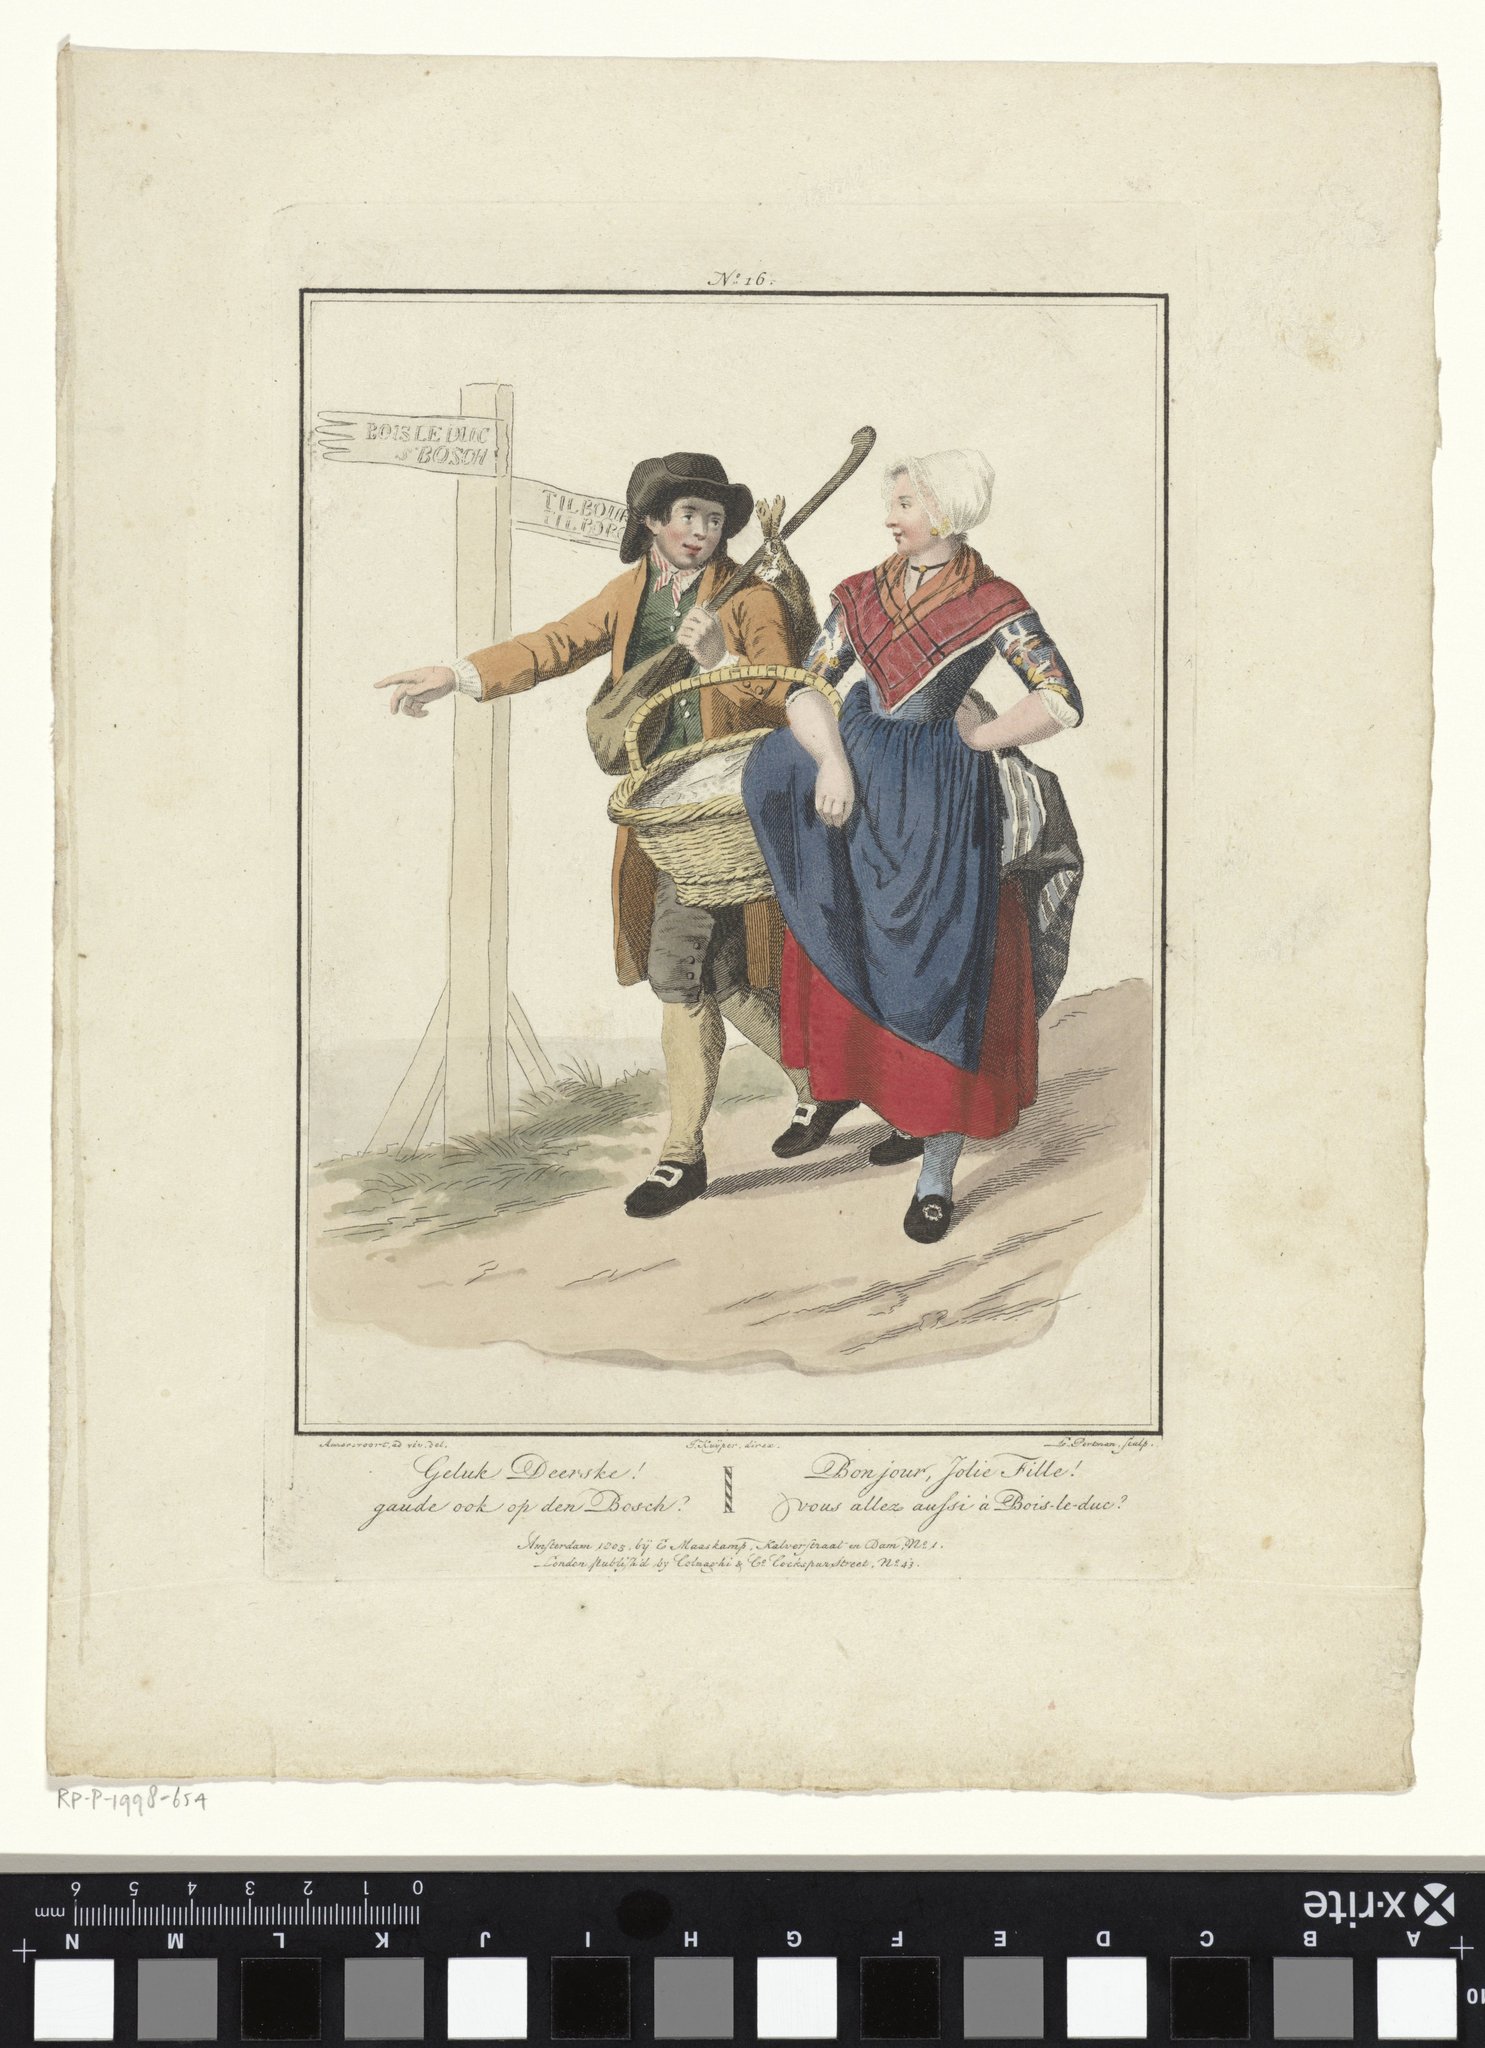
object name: costume print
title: Brabantse boer en boerin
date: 1803-1807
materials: paper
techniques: etching, hand coloring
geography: amsterdam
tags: signpost, folk costume, regional costume, brabant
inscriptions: signature and date: ‘L. Portman sculp.; l.o.: Amersvoort ad viv. del.; m.o. Kuyper direx.; m.o. Amsterdam 1805, bij Maaskamp....London, published by Colnaghi & Cie...’, inscription: ‘Geluk, Deerske ! gaude ook op den Bosch ? // Bonjour, jolie Fille, vous allez aussi a Bois-le-duc? mb.: No. 16’, collector's mark: Lugt 2228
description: Illustratie uit: Afbeeldingen van de kleeding, zeden en gewoonten in de Bataafsche Republiek, met den aanvang der negentiende eeuw. Amsterdam: Evert Maaskamp, 1803-1807.